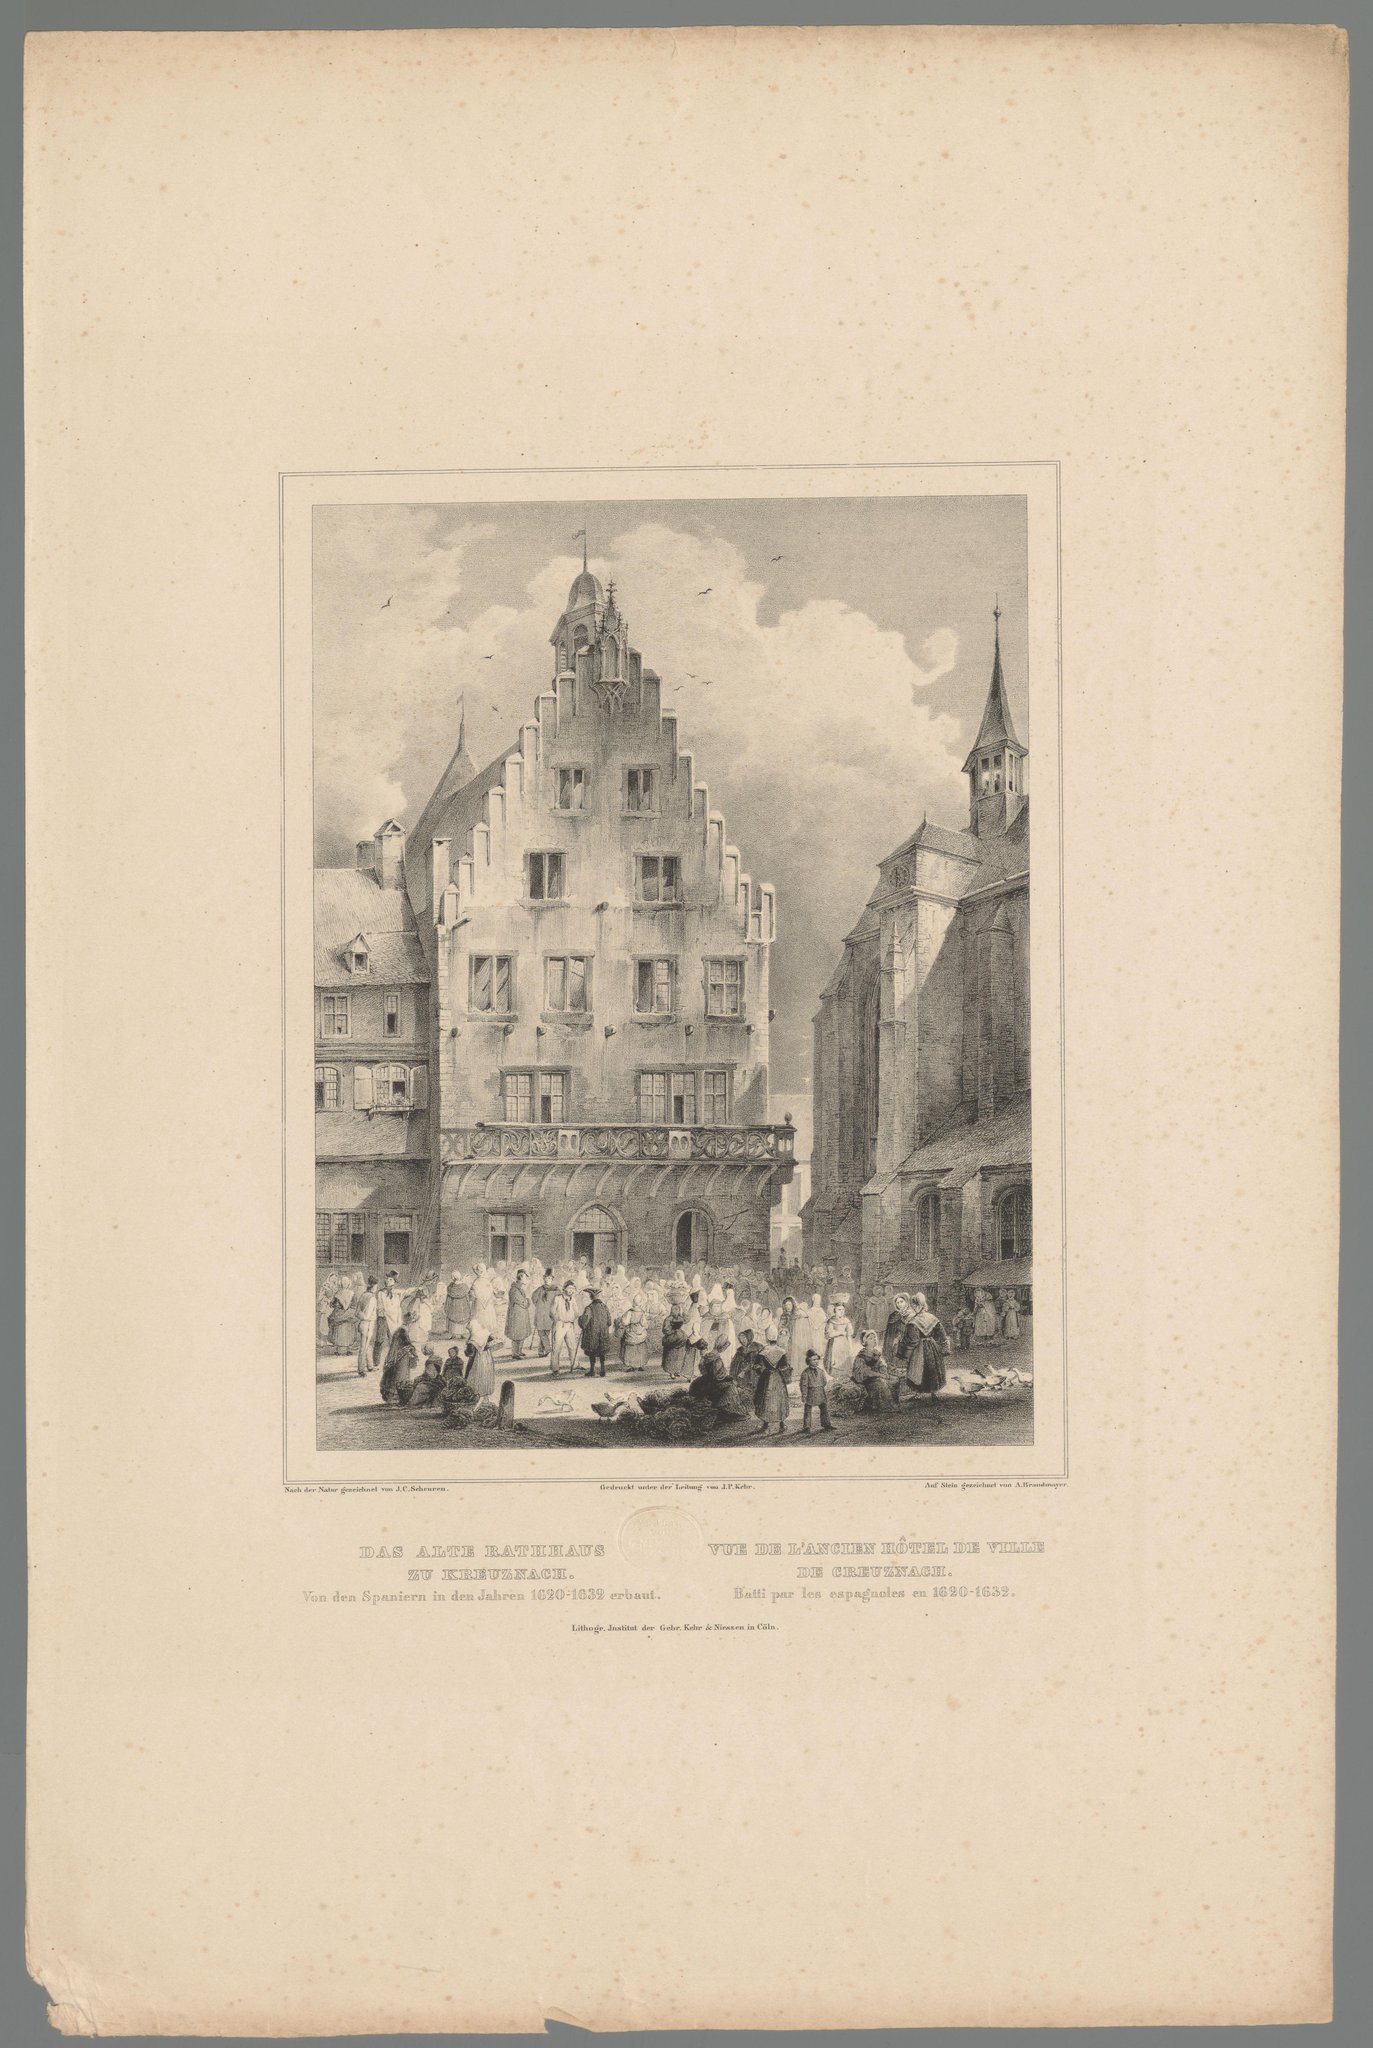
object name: print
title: Das Nahe-Thal. Von dem Ursprunge der Nahe bis zu ihrer Mündung in den Rhein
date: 1834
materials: paper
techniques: lithograph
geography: cologne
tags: village square, place, city-view, and landscape with man-made constructions (+ city(-scape) with figures, staffage), municipal government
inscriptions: check stamp: ‘Verlag von L. Niessen in Cöln’, collector's mark: Lugt 2228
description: De serie 'Das Nahe-Thal. Von dem Ursprunge der Nahe bis zu ihrer Mündung in den Rhein' is uitgegeven in vijf delen van elk vier prenten vervaardigd door A. Brandmayer en Andreas Borum. Tien prenten uit deze serie zijn daarnaast waarschijnlijk ook nog samen onder de titel 'Kreuznach und seine Umgebung. Erinnerung an seine Heilquellen und das Nahe-Thal' uitgegeven.